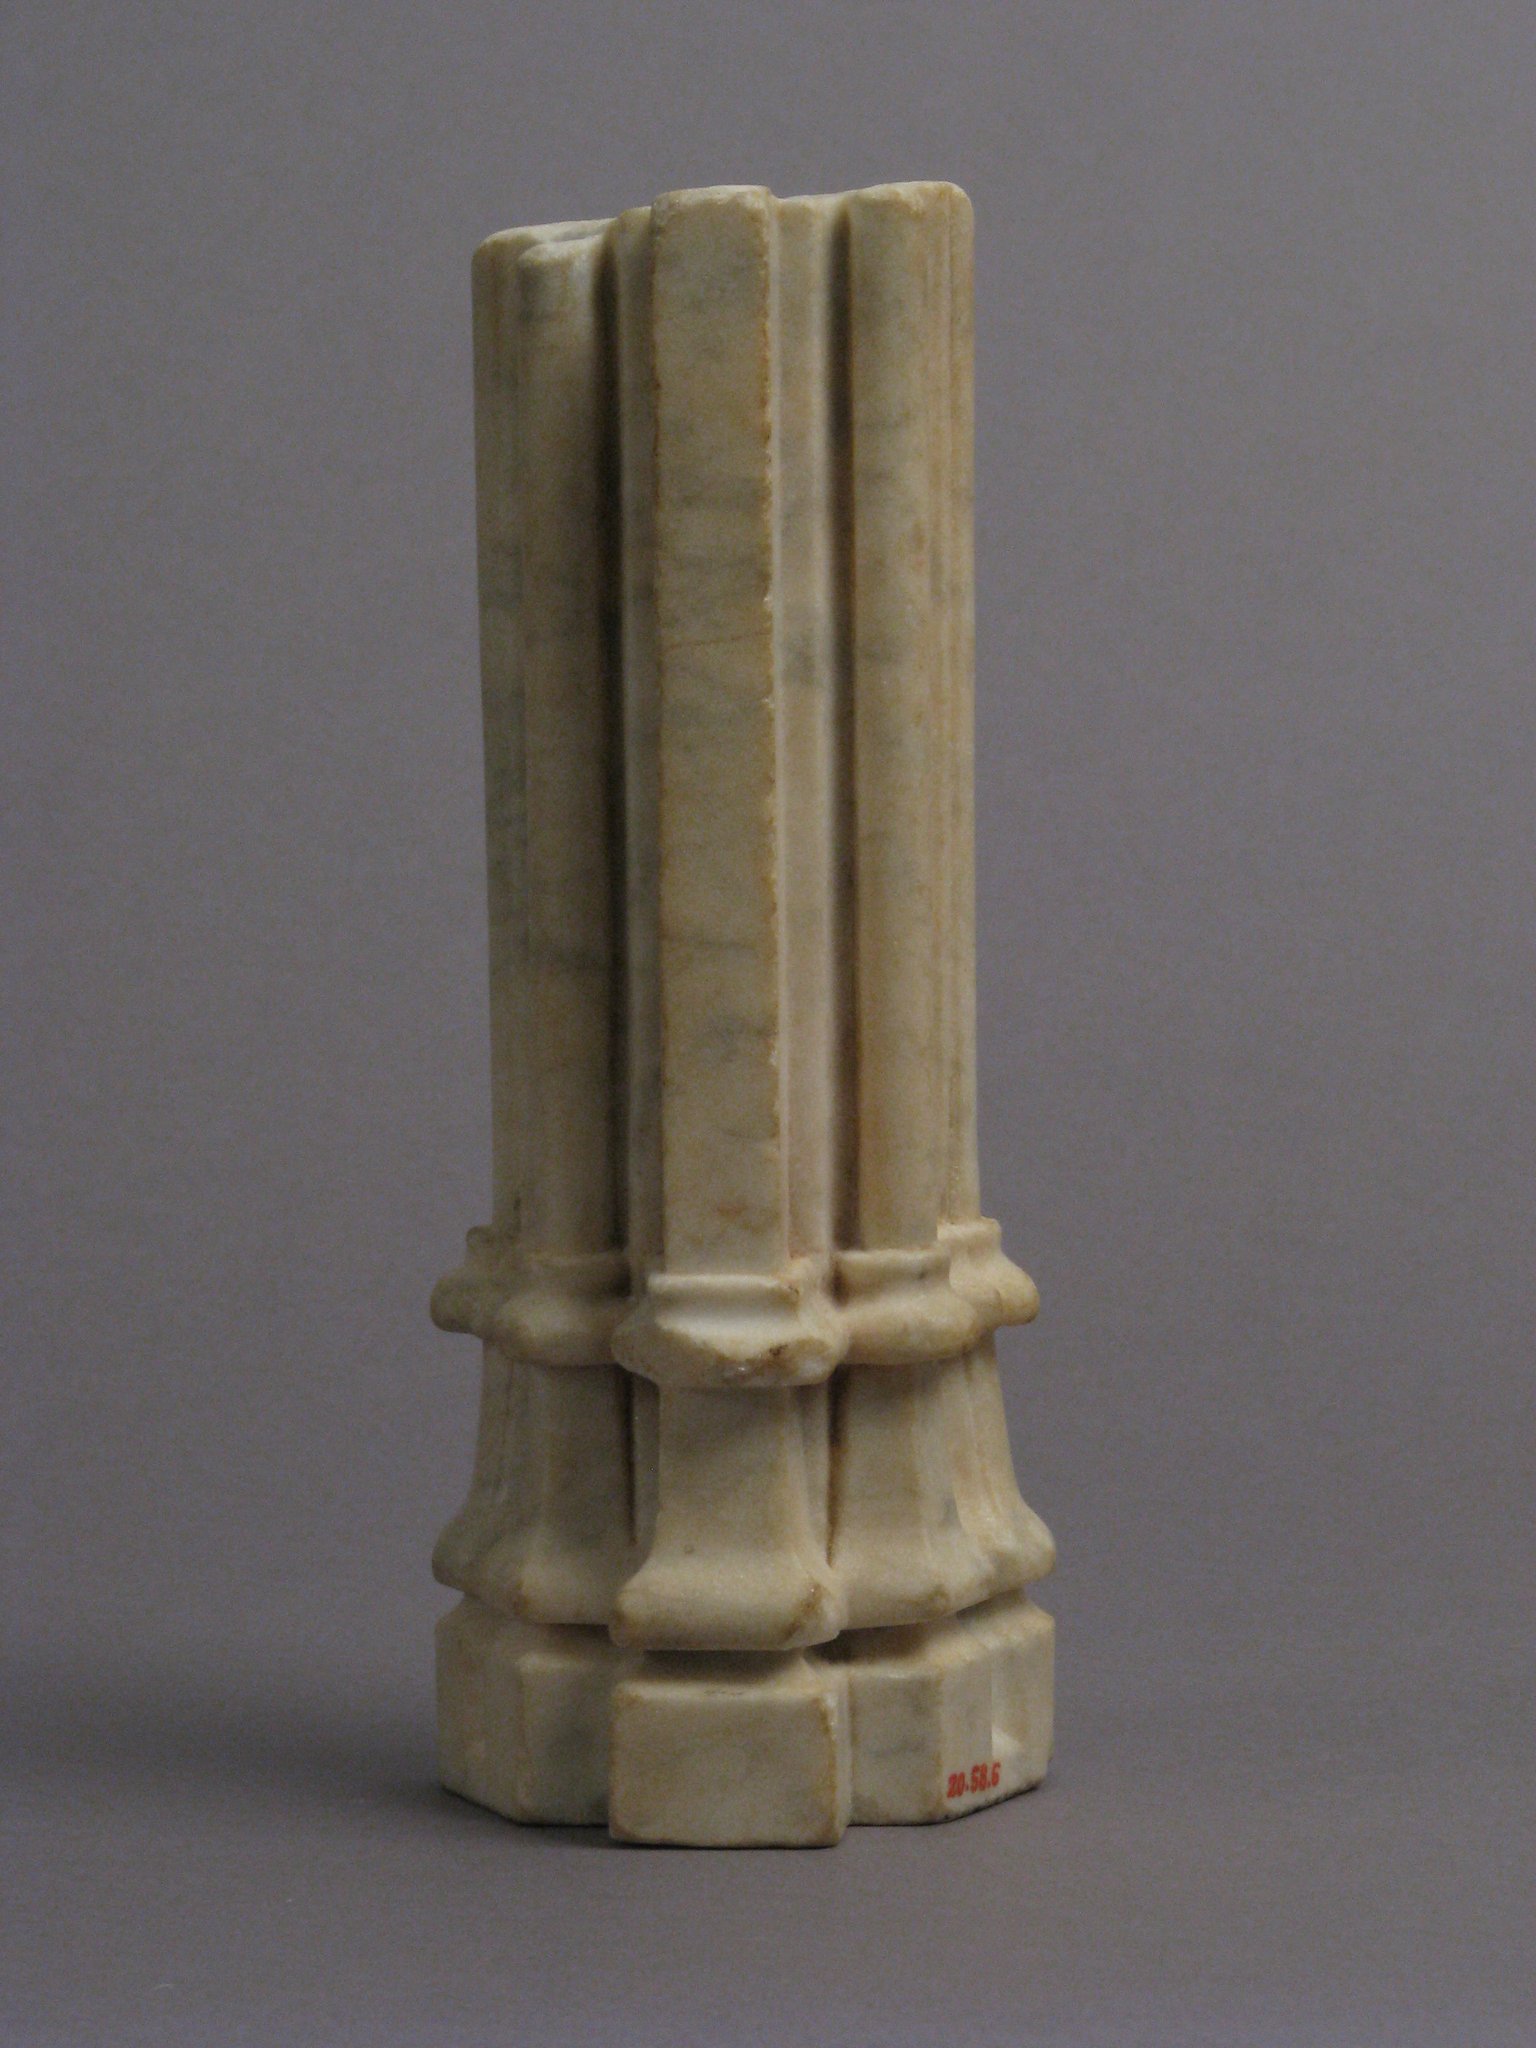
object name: relief fragment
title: Architectural Fragment from a Retable, Tabernacle, or Tomb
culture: french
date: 1400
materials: marble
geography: france